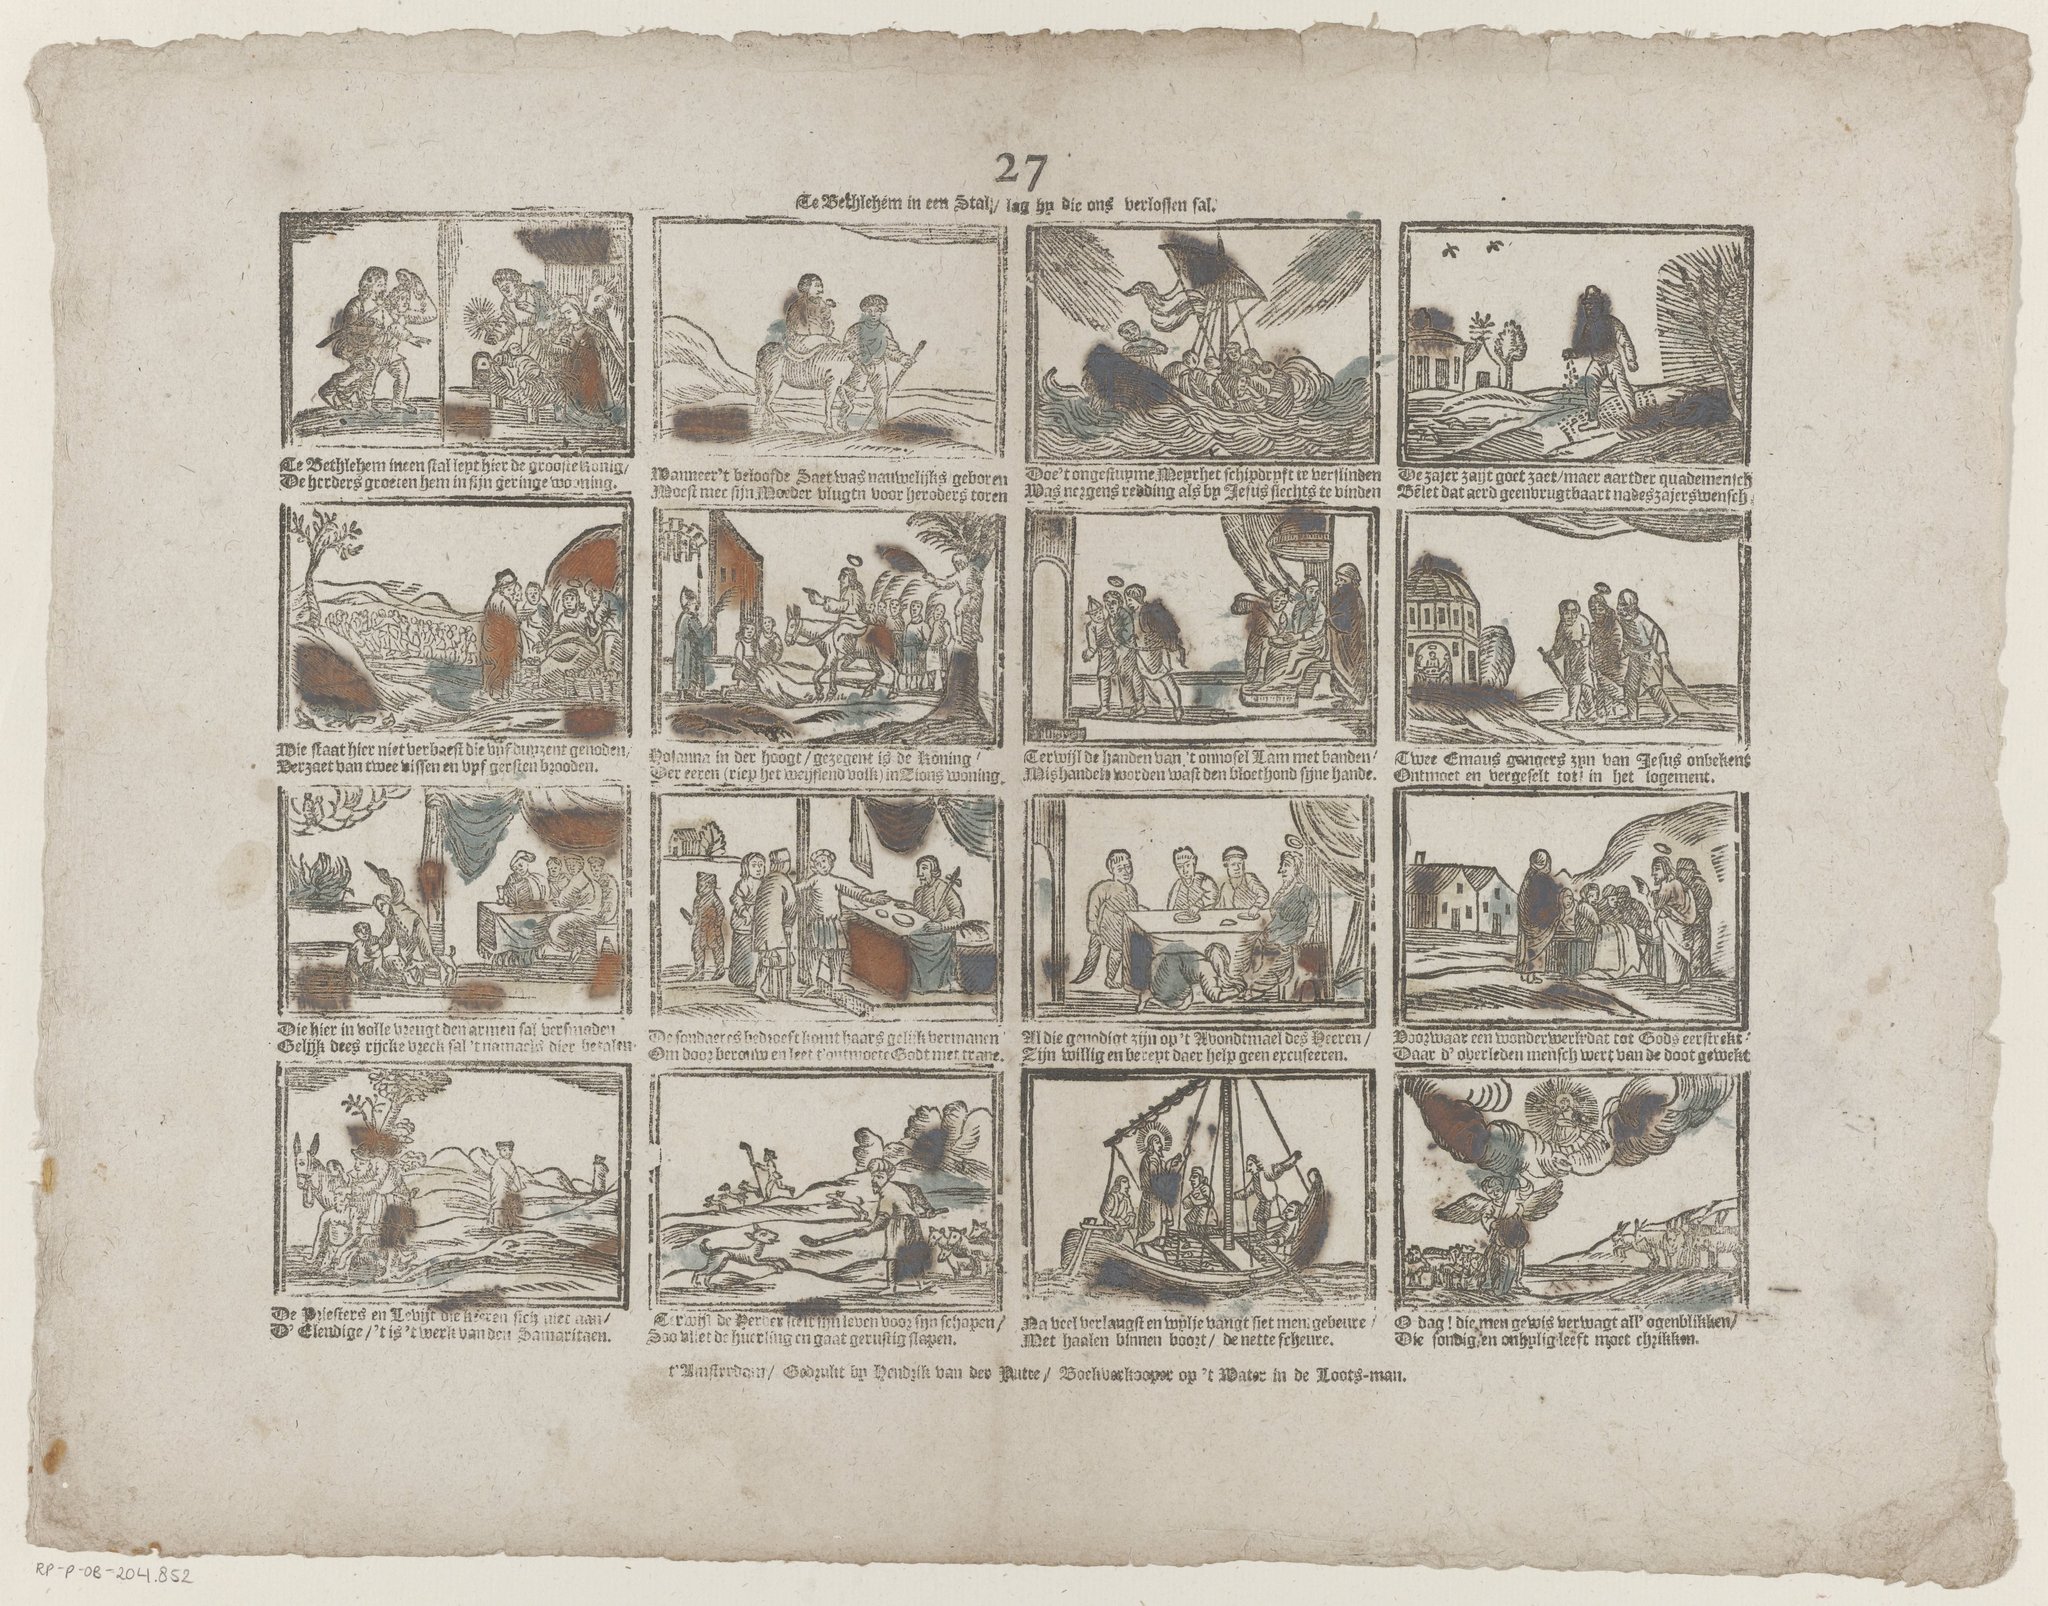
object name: popular print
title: Te Bethlehem in een stal / lag hy die ons verlossen zal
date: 1761-1765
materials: paper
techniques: colour, letterpress printing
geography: netherlands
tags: new testament, series of scenes from the life of christ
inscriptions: collector's mark: Lugt 2760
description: Blad met 16 voorstellingen van verhalen uit het Nieuwe Testament, zoals de vlucht naar Egypte en de intocht in Jeruzalem. Onder elke afbeelding een tweeregelig vers. Genummerd midden boven: 27.